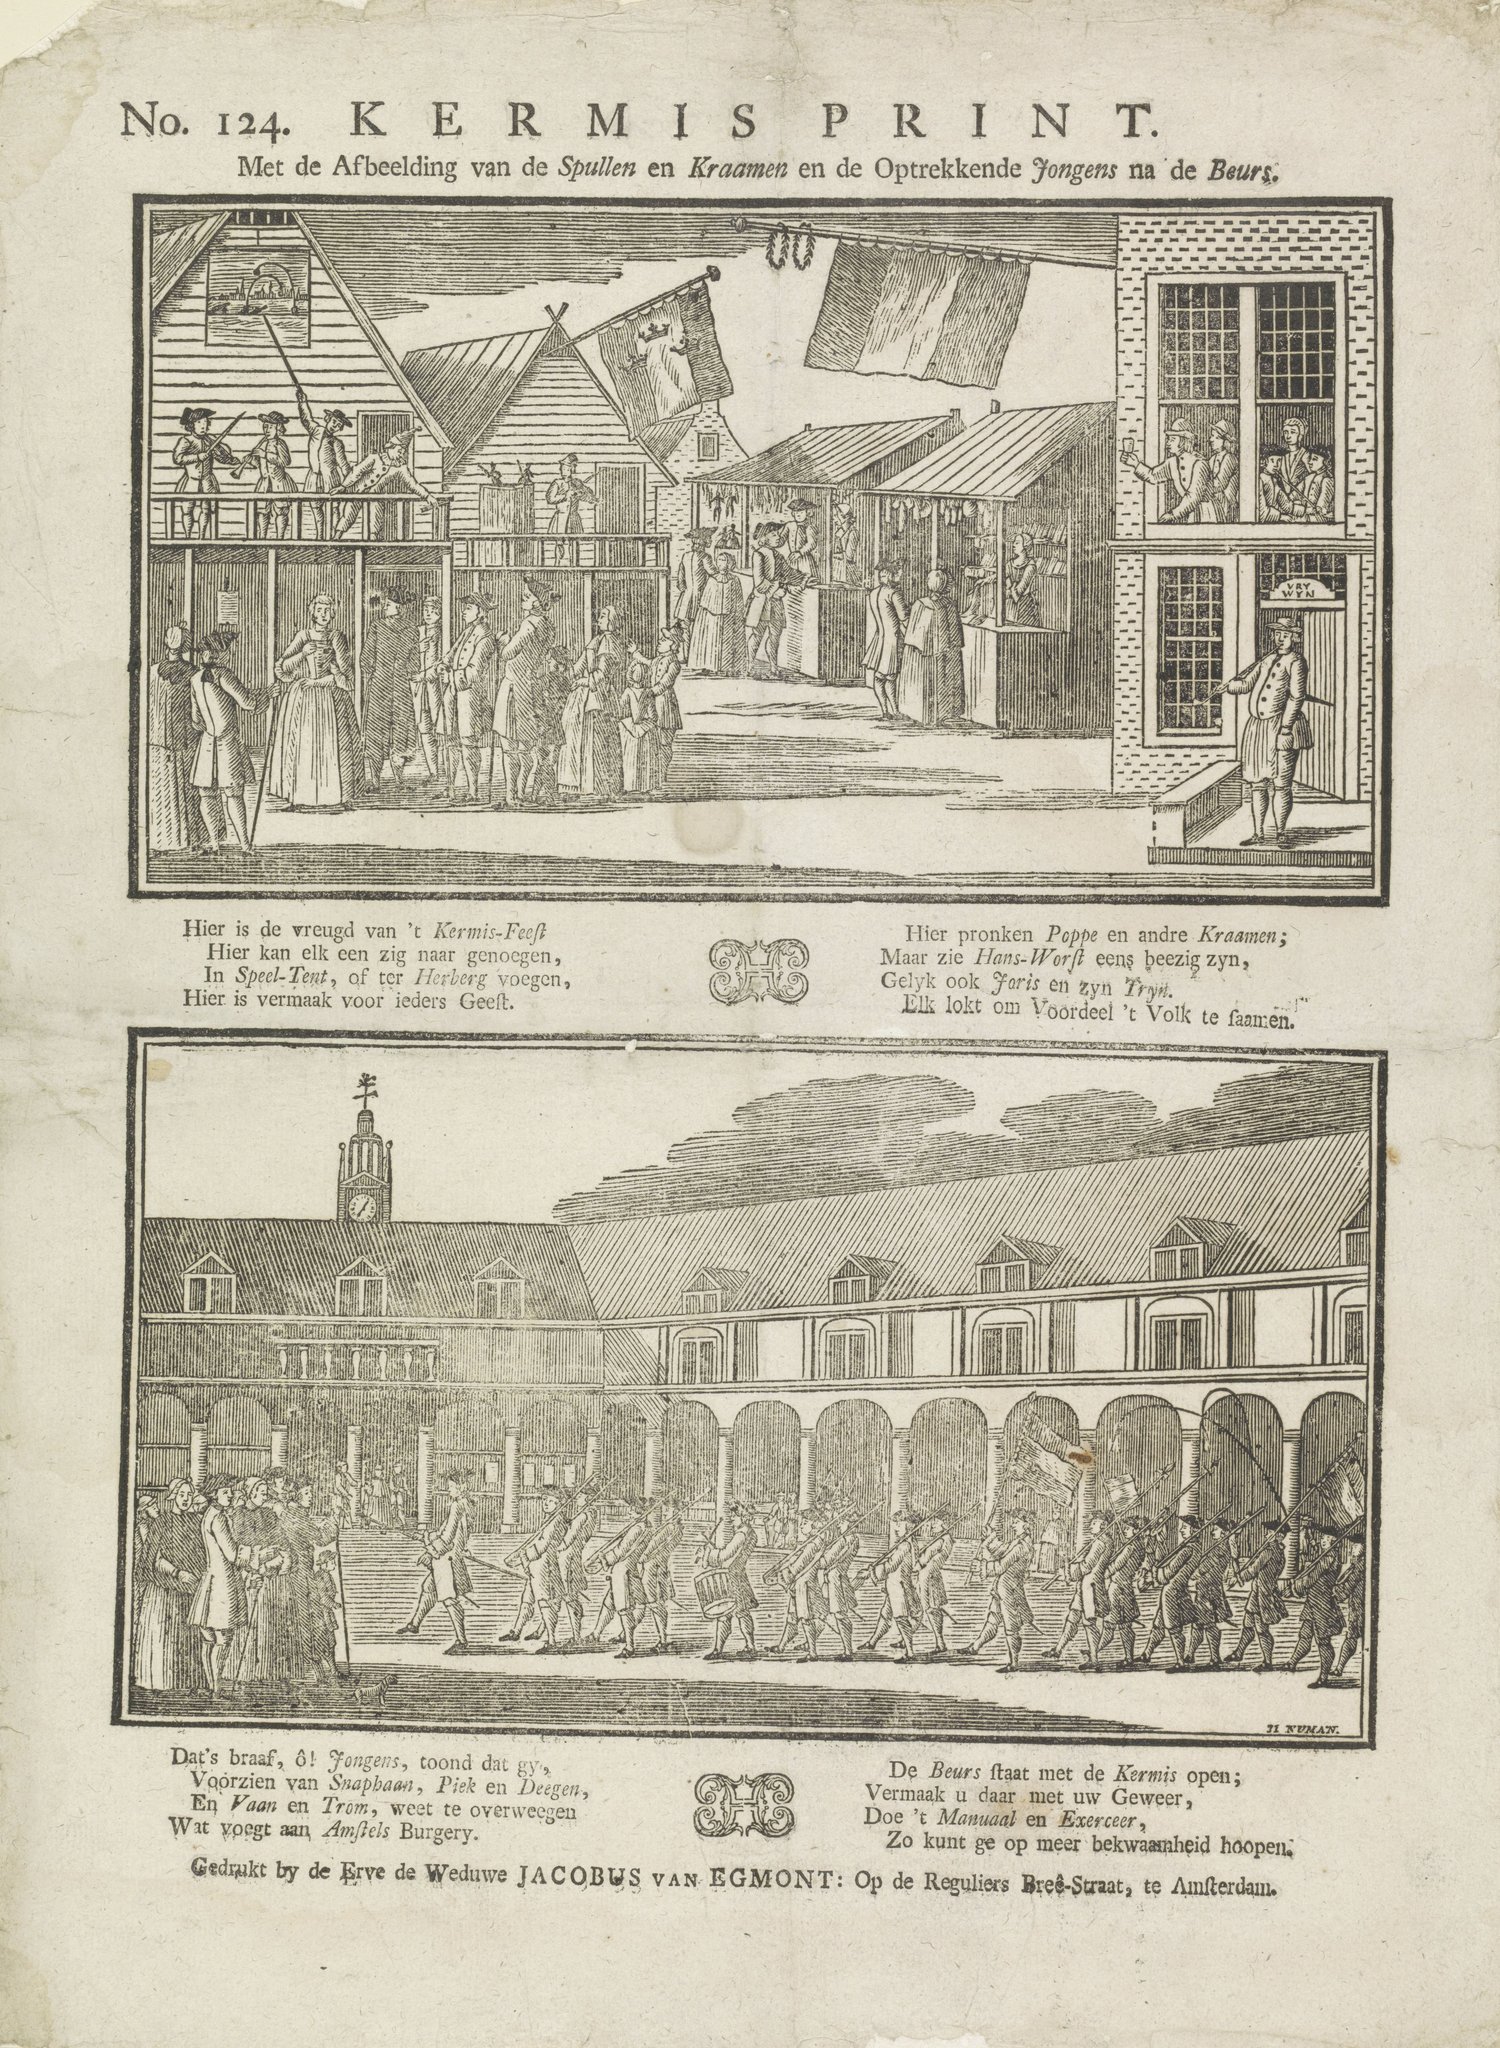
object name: popular print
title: Kermis print. / Met de afbeelding van de spullen en kraamen op de optrekkende jongens na de beurs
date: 1771-1804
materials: paper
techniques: letterpress printing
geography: amsterdam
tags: military training, pleasure fair and circus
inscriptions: collector's mark: Lugt 2228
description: Blad met 2 voorstellingen. Boven de kermis op de Botermarkt, met diverse kramen. Onder exercitie van de burgerwacht bij de beurs, te Amsterdam. Onder beide voorstellingen een achtregelig vers in twee kolommen. Genummerd linksboven: No. 124.